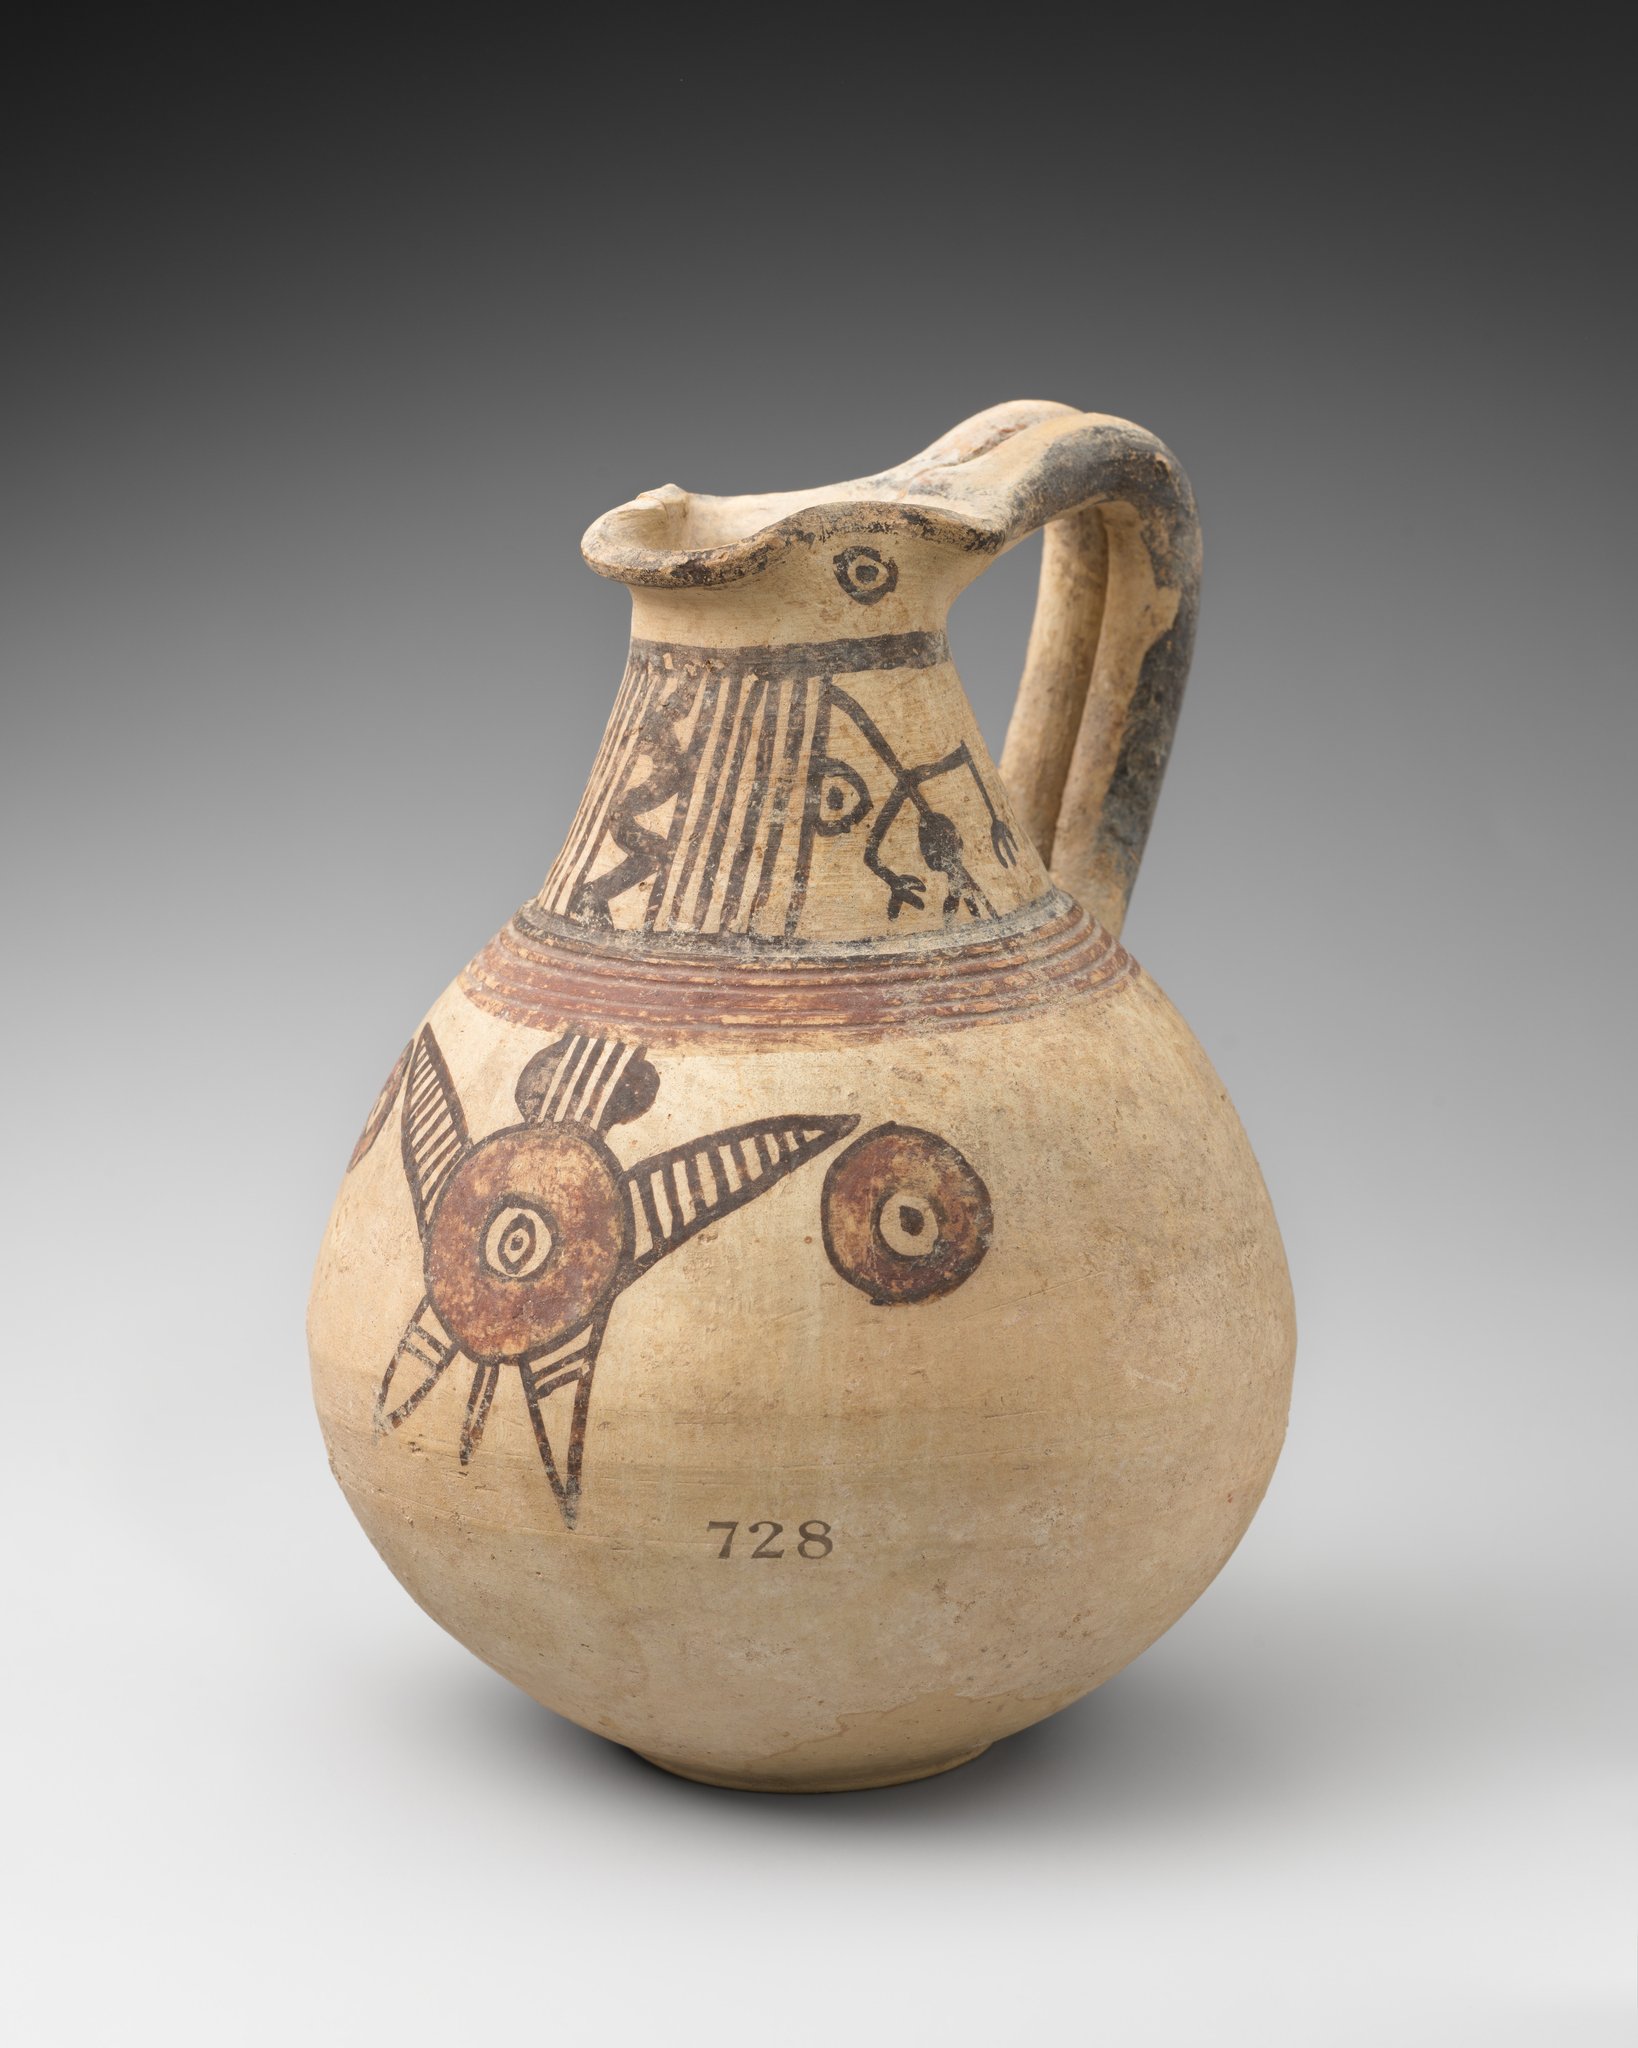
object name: jug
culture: cypriot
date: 750-600 BCE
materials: terracotta